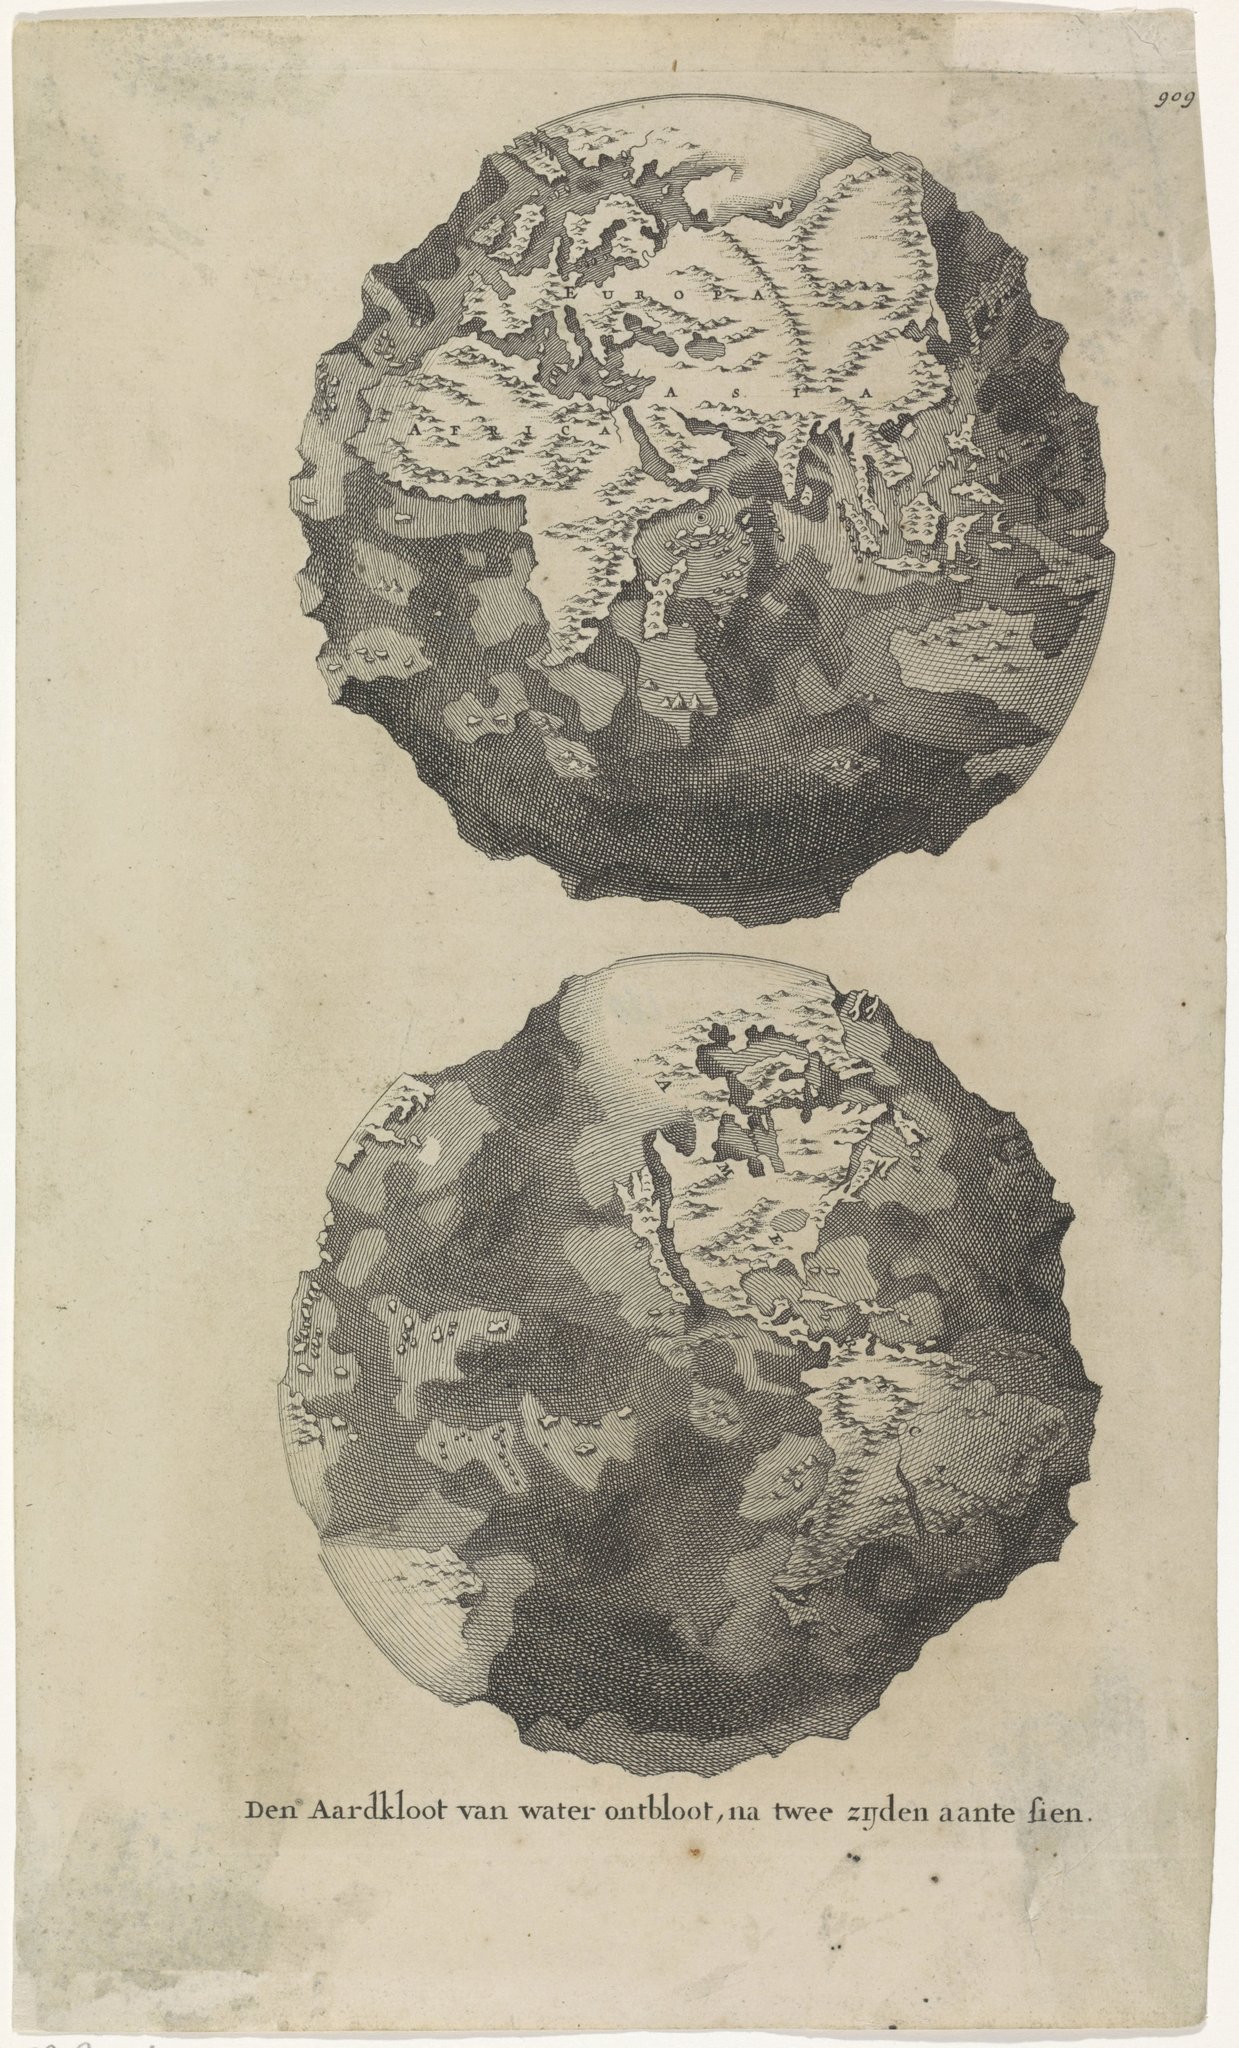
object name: print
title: Twee aanzichten van de aardbol zonder water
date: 1690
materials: paper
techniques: etching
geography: amsterdam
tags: earth, world as celestial body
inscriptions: collector's mark: Lugt 2228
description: Mogelijk gebruikt als boekillustratie in: Goeree, Willem. Voor-bereidselen tot de bybelsche wysheid, en gebruik der heilige en kerklijke historien. 2 delen. Amsterdam: Willem Goeree, 1690.